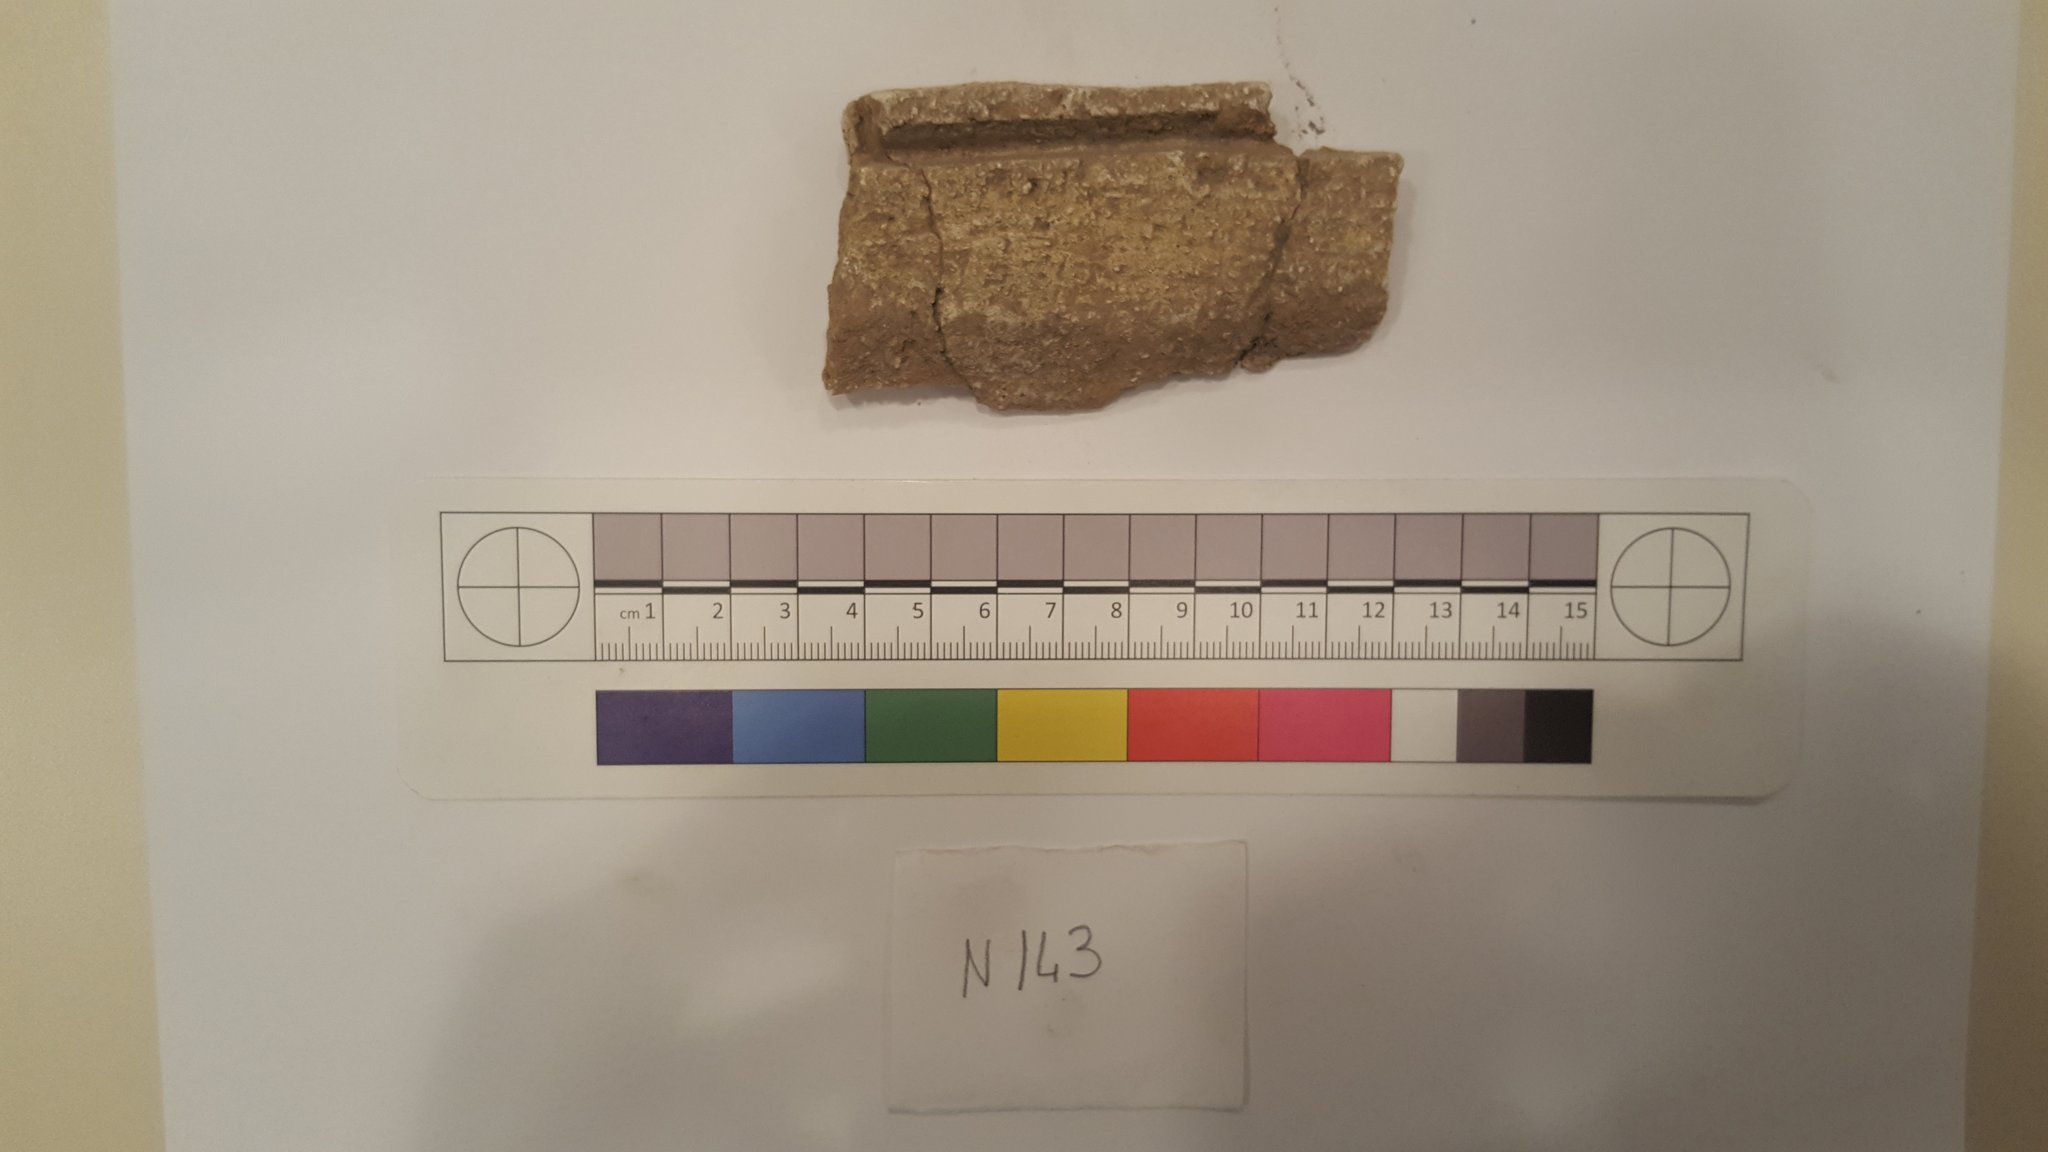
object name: fragment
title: Stucco Fragment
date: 701-1200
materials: plaster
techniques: carving, painting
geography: iran